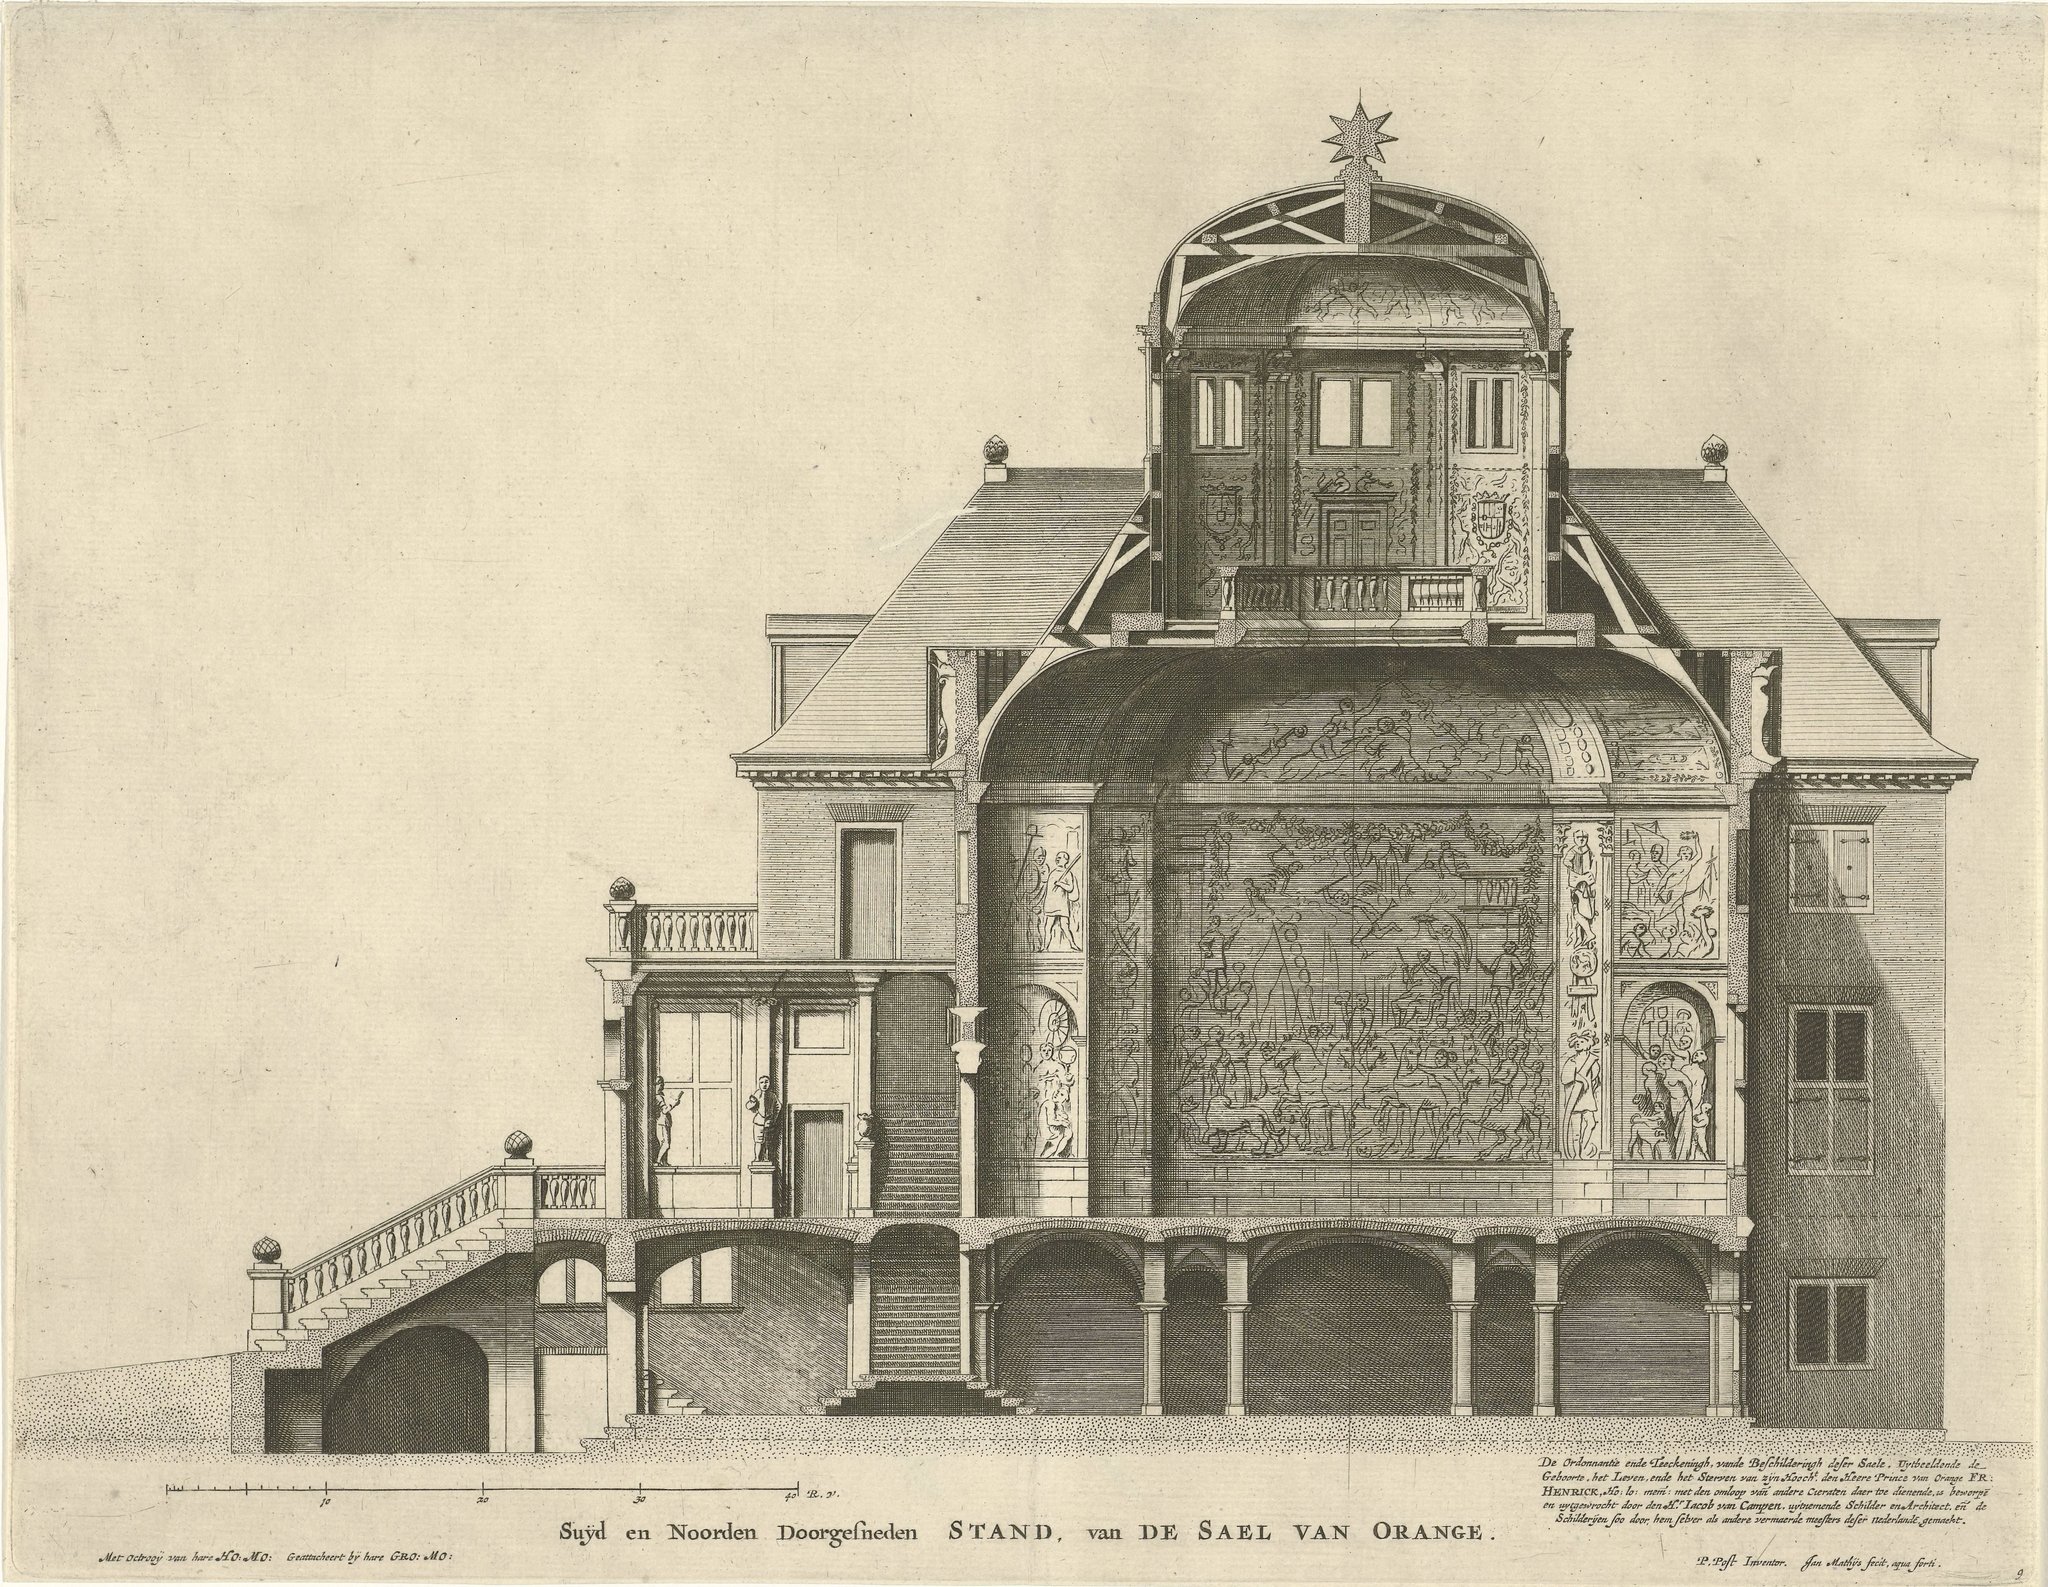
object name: print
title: Doorsnede van Paleis Huis ten Bosch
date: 1655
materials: paper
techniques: etching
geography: amsterdam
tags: palace, section ~ architectural design or model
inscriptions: collector's mark: Lugt 2228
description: Doorsnede van Paleis Huis ten Bosch te Den Haag met de schilderingen in de Oranje Zaal.